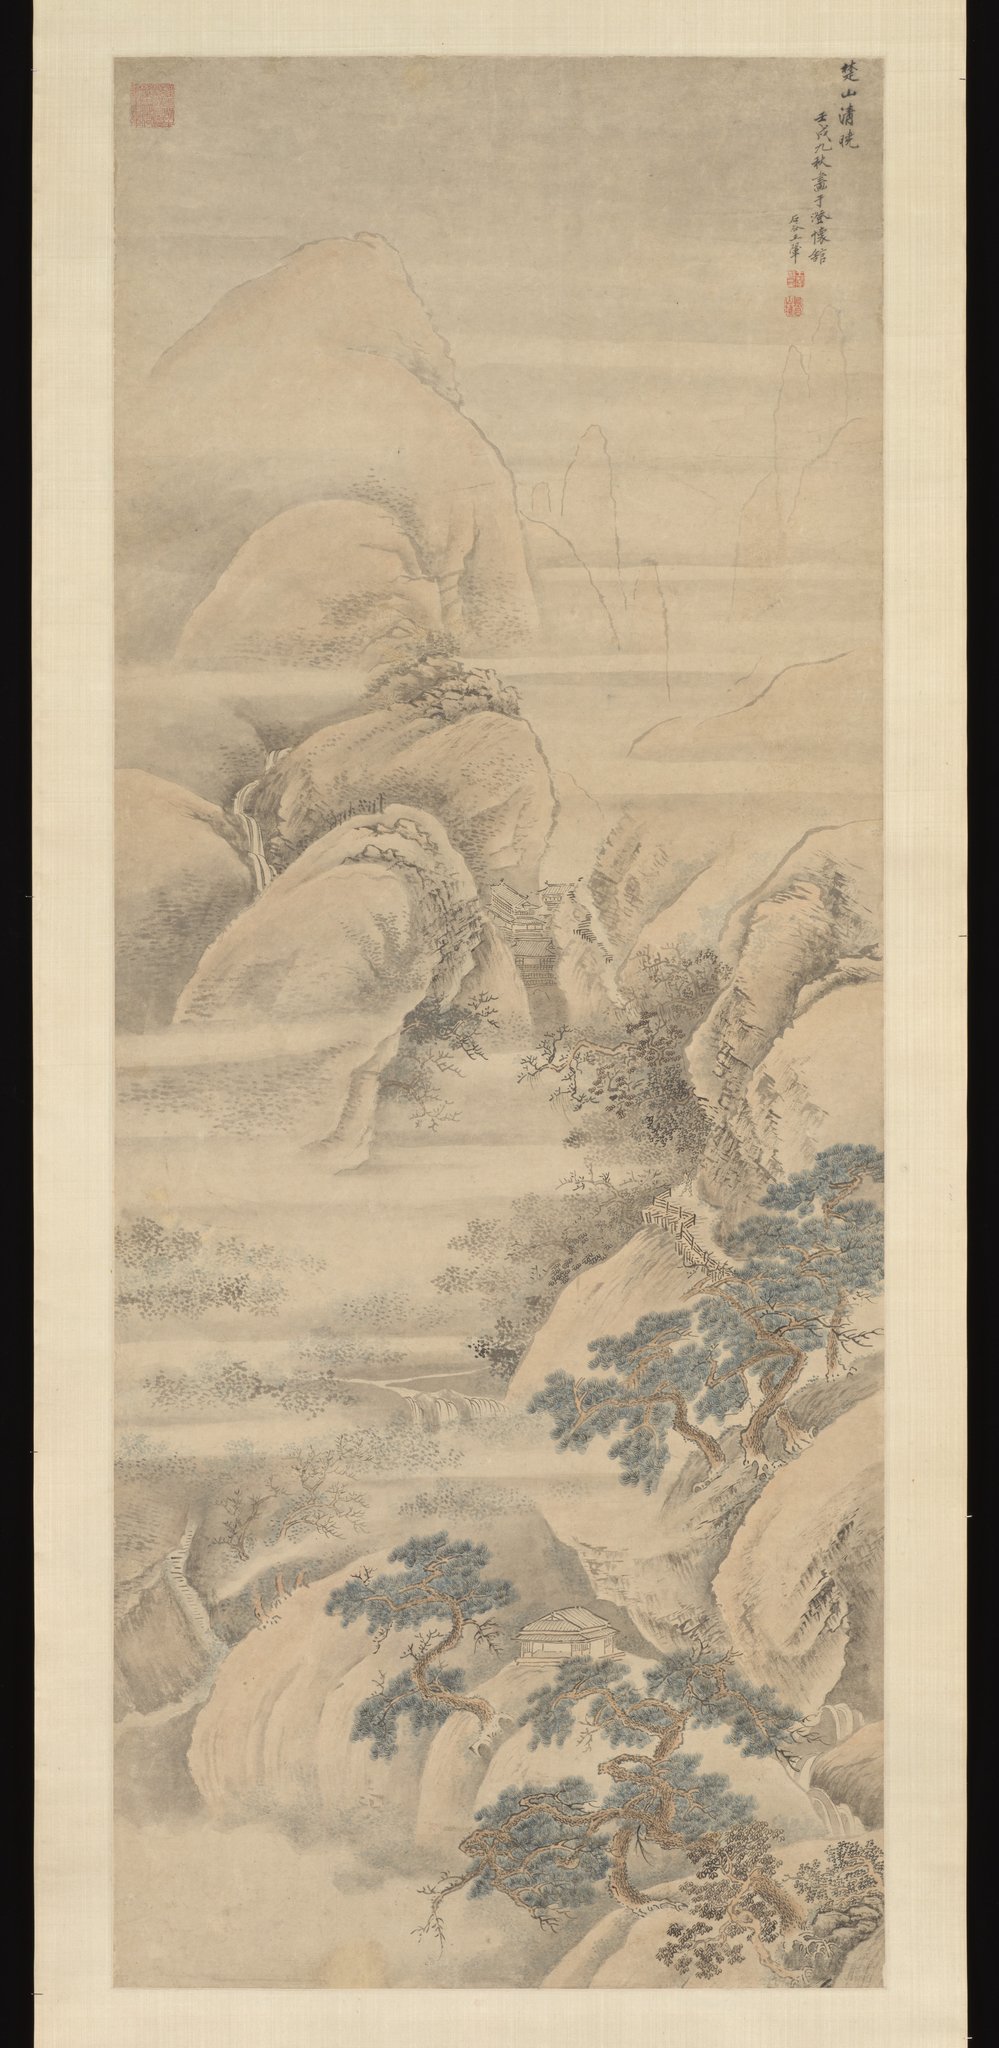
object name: hanging scroll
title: Snowscape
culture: chinese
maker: unidentified artist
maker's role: artist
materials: ink, paper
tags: mountains,landscapes,snow